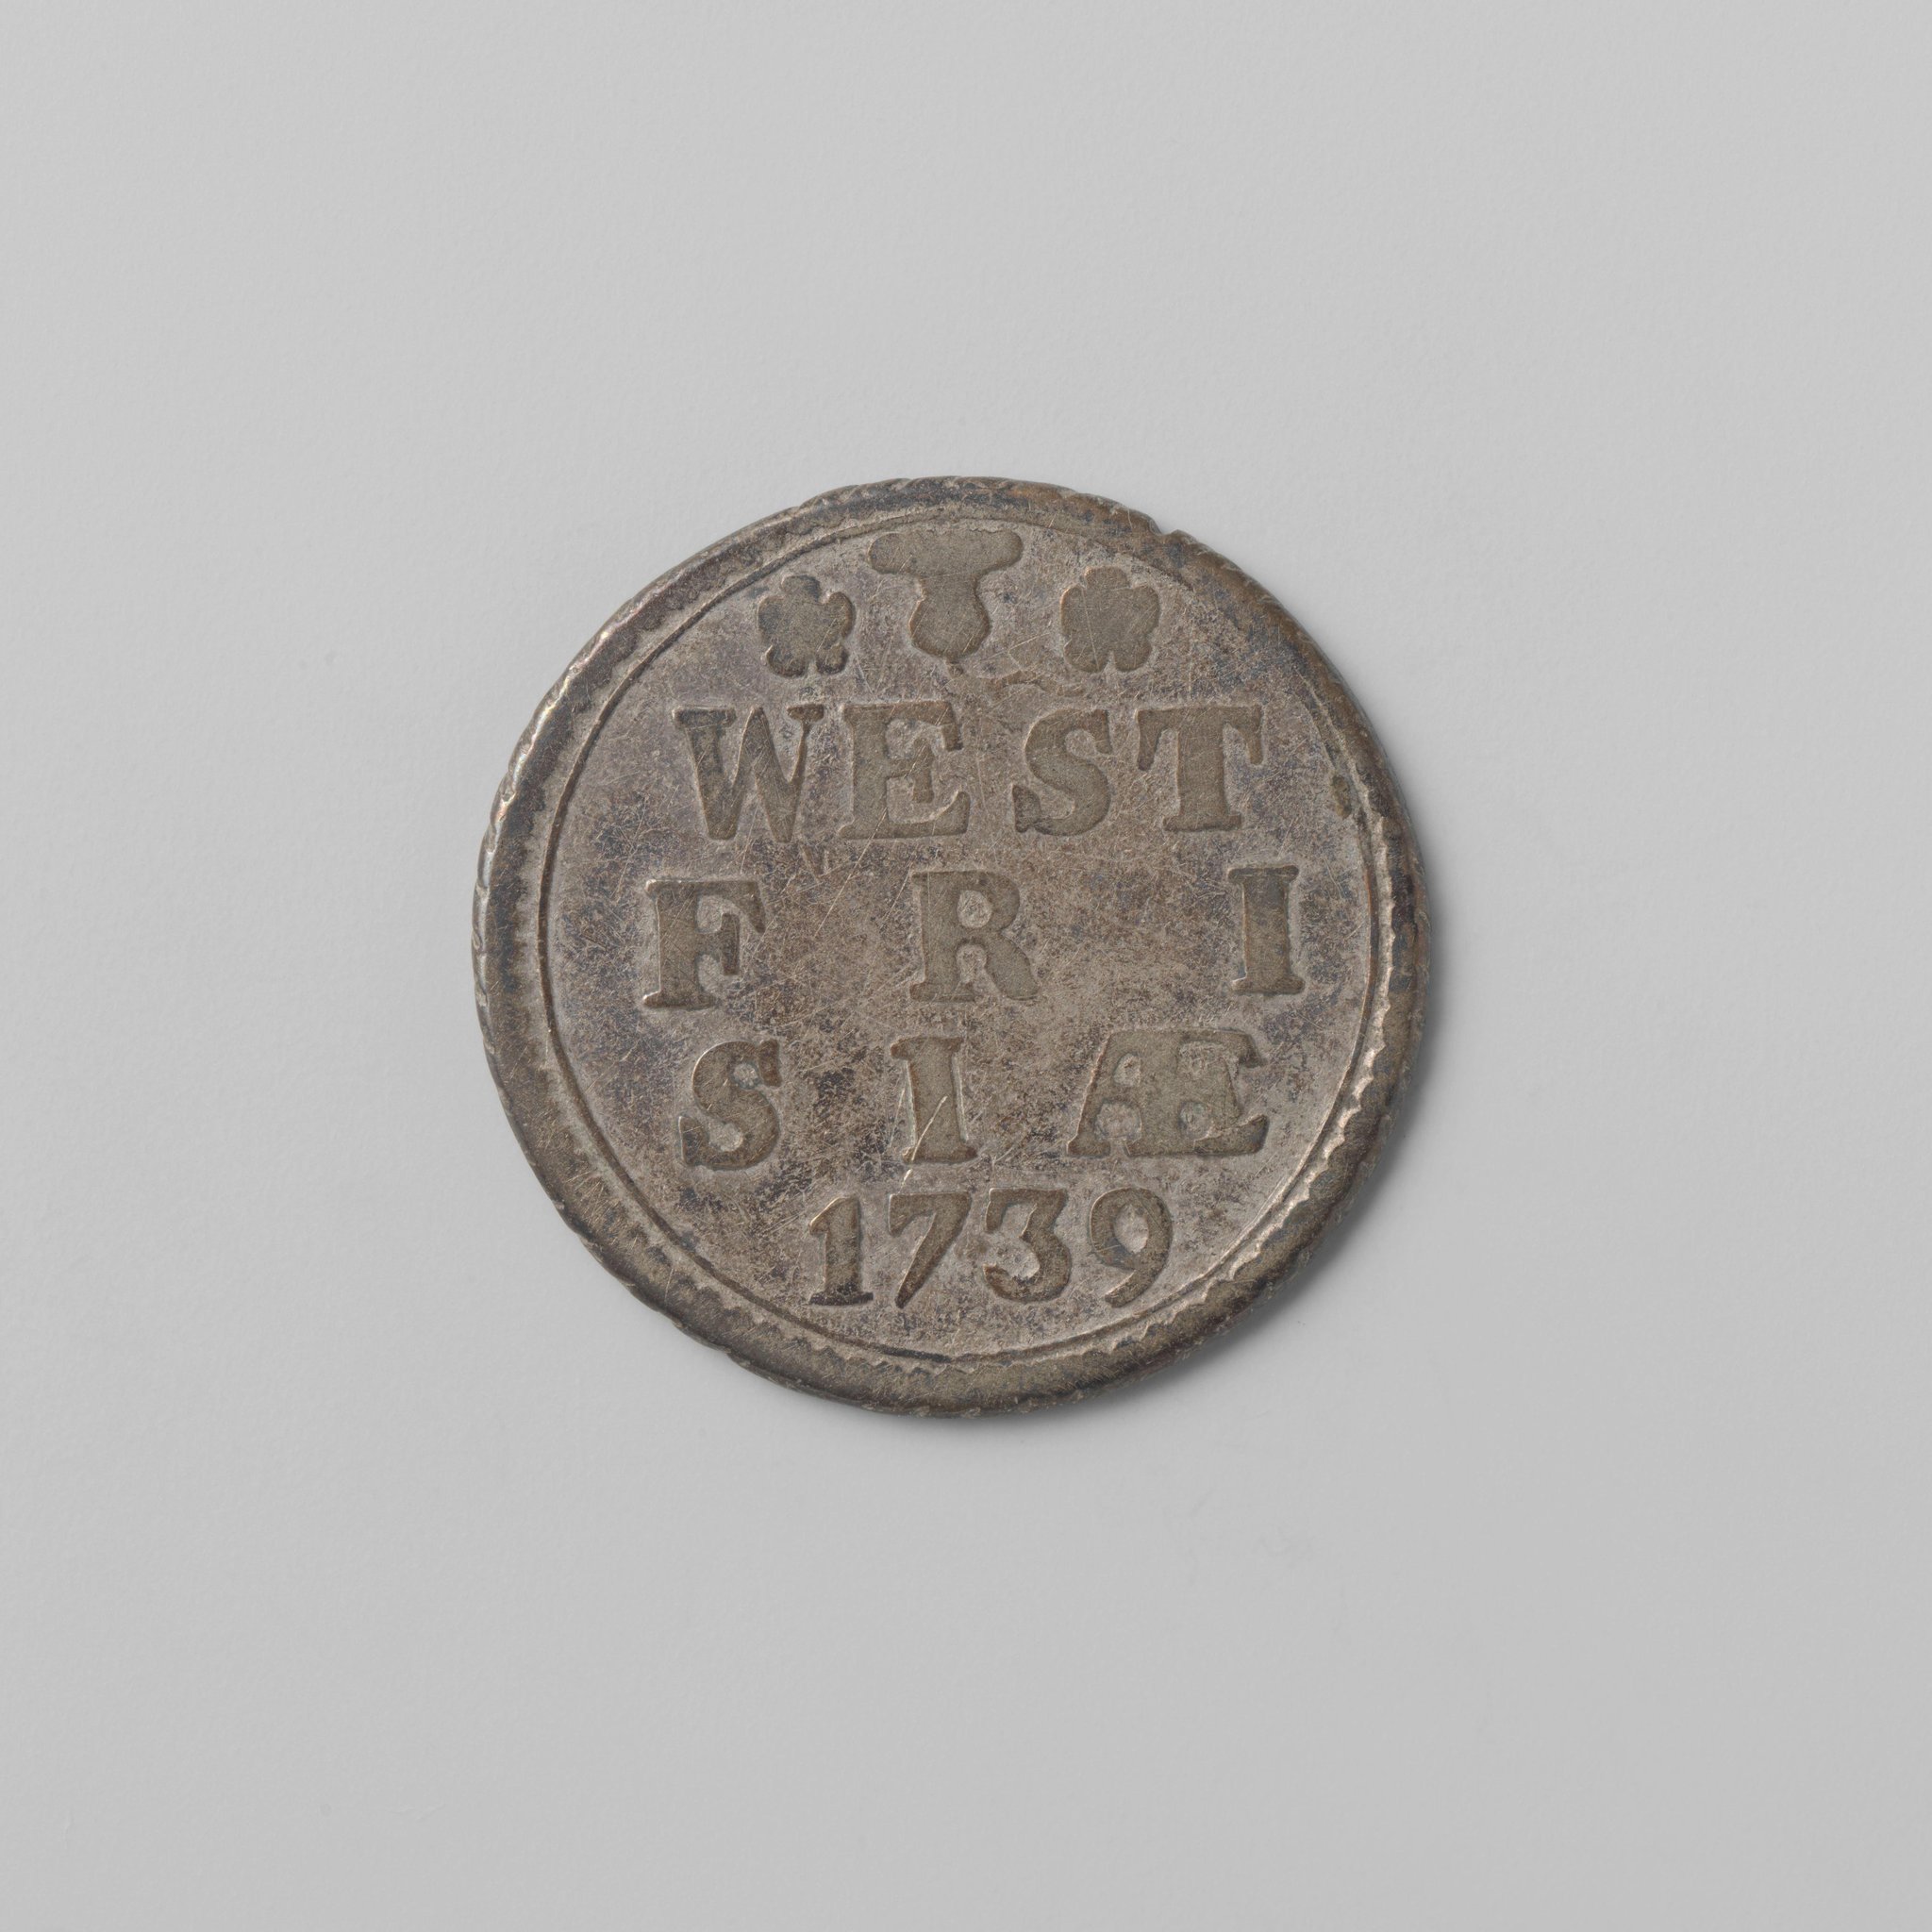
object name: coin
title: West-Friesland, duit, 1739. Afslag in zilver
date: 1739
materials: silver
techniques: striking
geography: west frisia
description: Zilveren munt. Voorzijde: gekroond wapenschild van West-Friesland met lauwertakken. Keerzijde: opschrift in drie regels. Daarboven muntmeesterteken knol tussen twee rozetten. Daaronder jaartal. Afslag in zilver.